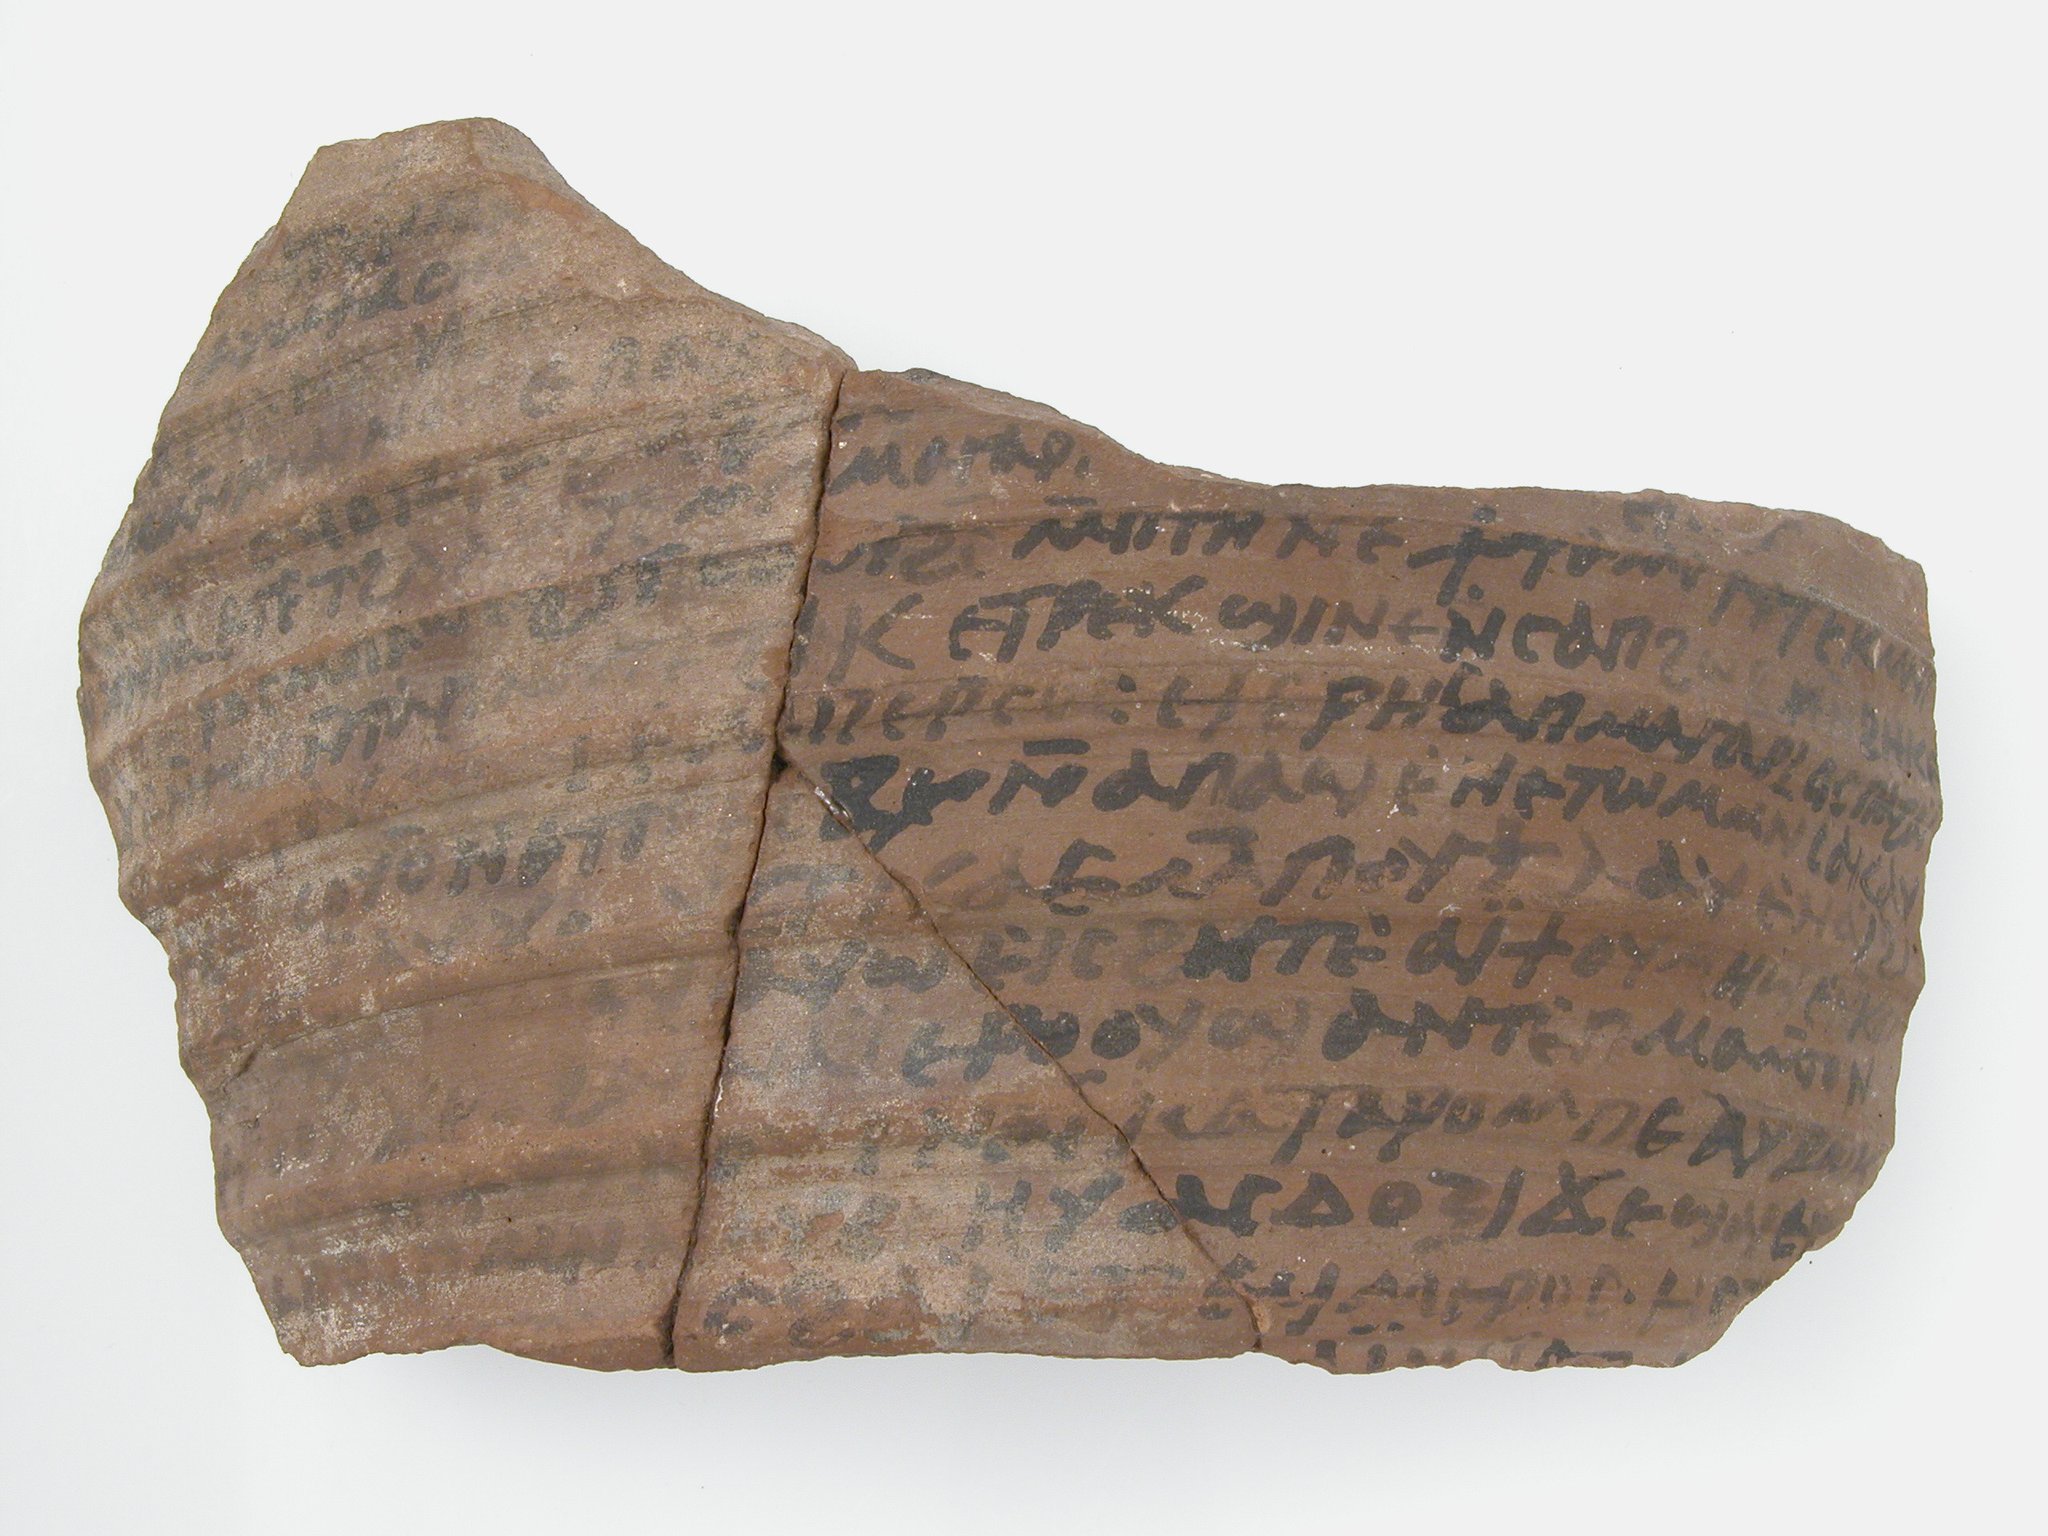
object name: ostrakon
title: Ostrakon with a Letter from Thello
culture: coptic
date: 580-640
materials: ink, pottery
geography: egypt